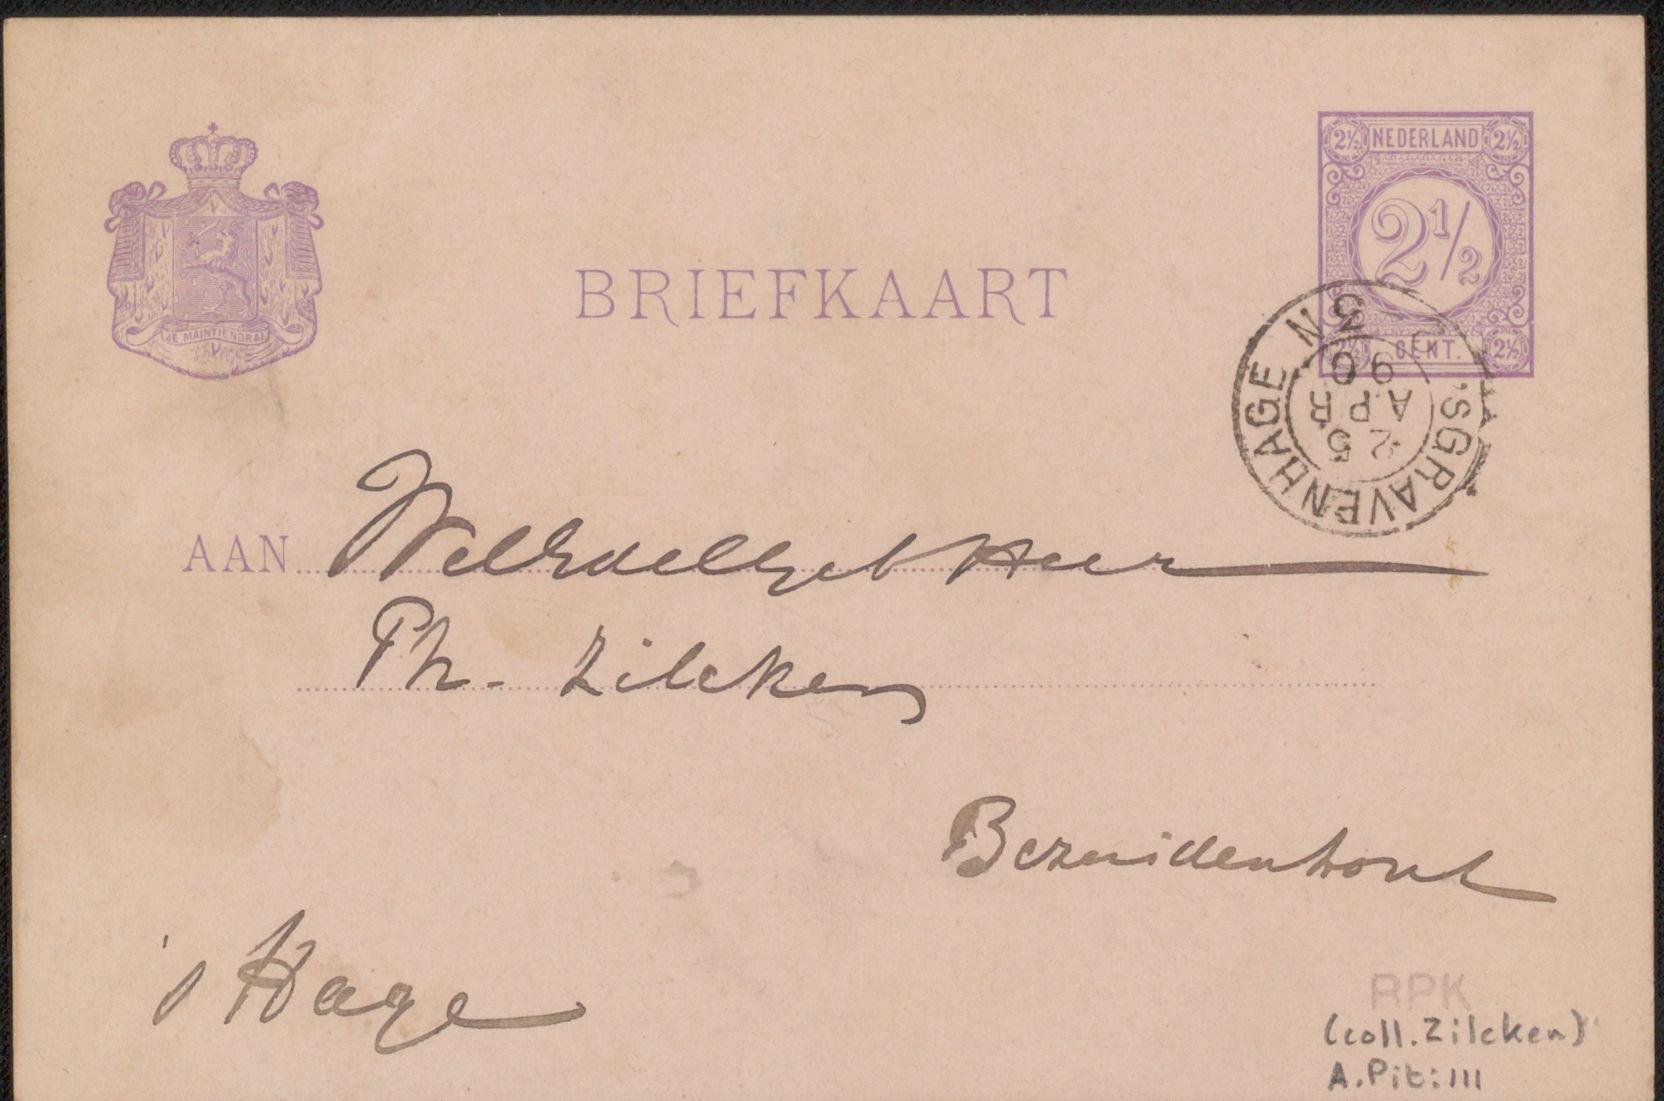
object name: postcard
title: Briefkaart aan Philip Zilcken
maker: adriaan pit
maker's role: print maker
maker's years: 1860-1944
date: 1890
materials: cardboard, ink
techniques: pen, writing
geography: the hague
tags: the hague, painter, draughtsman, philip zilcken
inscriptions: collector's mark: ‘RPK’